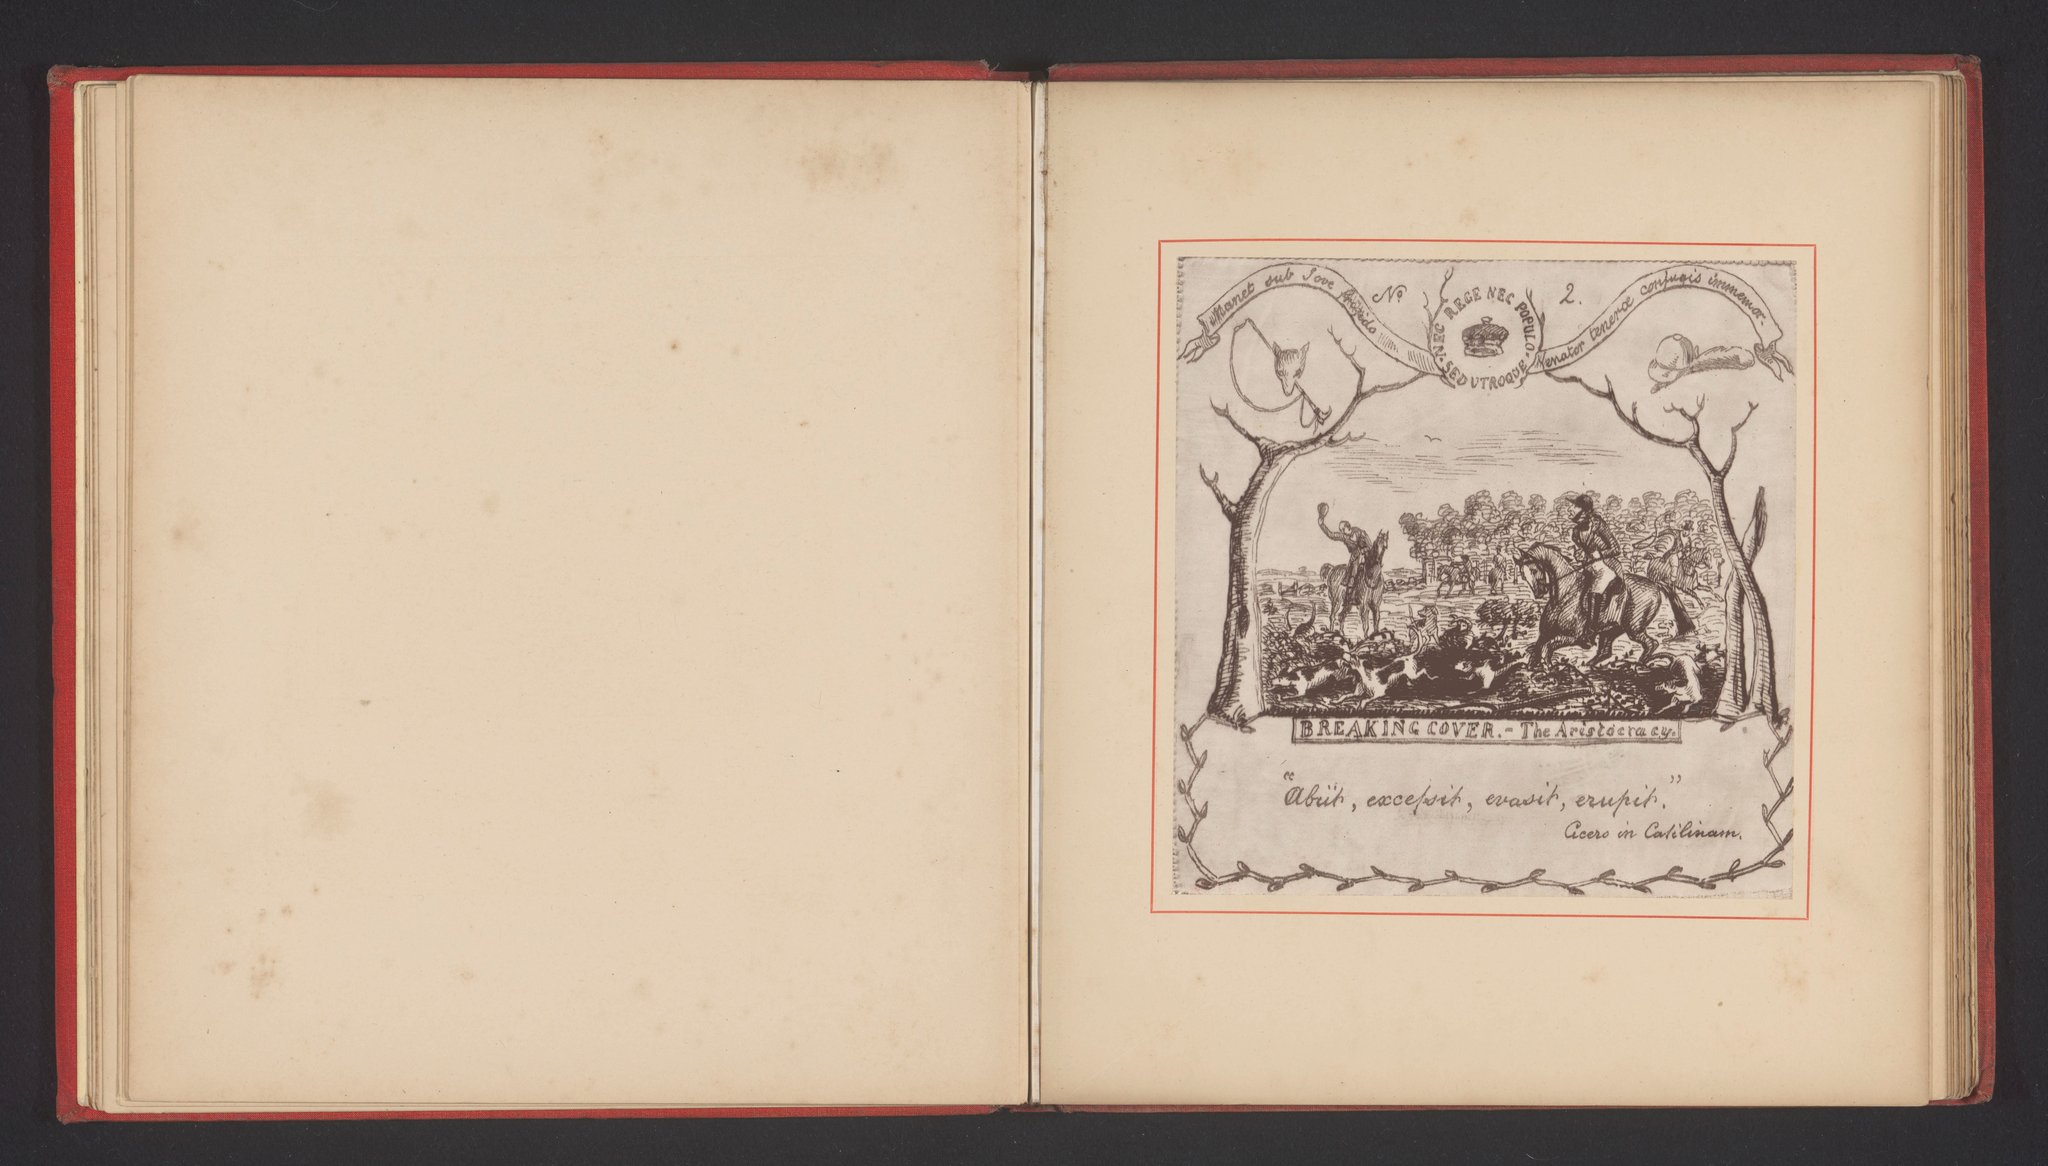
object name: photomechanical print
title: Breaking cover.- The Aristocracy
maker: Anonymous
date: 1875-1885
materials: paper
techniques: woodburytype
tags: drawing, sketch, hunting dogs, hunters hunting (n.b.: in 1988-1990 this notation denoted the concept of 43c11421 'hunters resting during the hunt')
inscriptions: inscription: ‘“Abü[...] , exc [...] ”Cicero in Catilinam.’, number: ‘No. 2.’